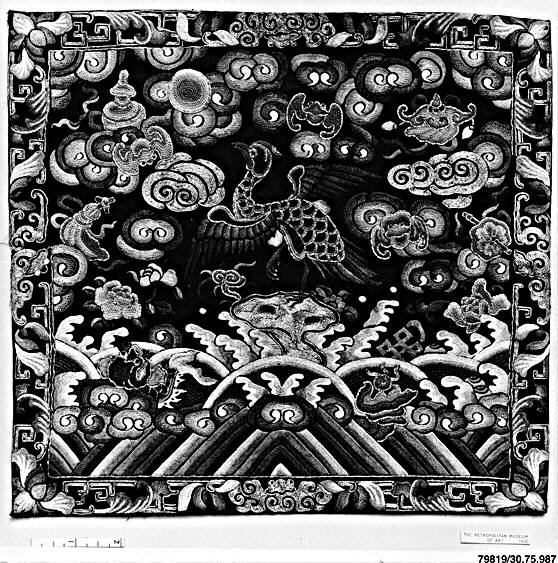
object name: rank badge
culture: chinese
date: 1734-1833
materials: metal thread, silk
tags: bats,ducks